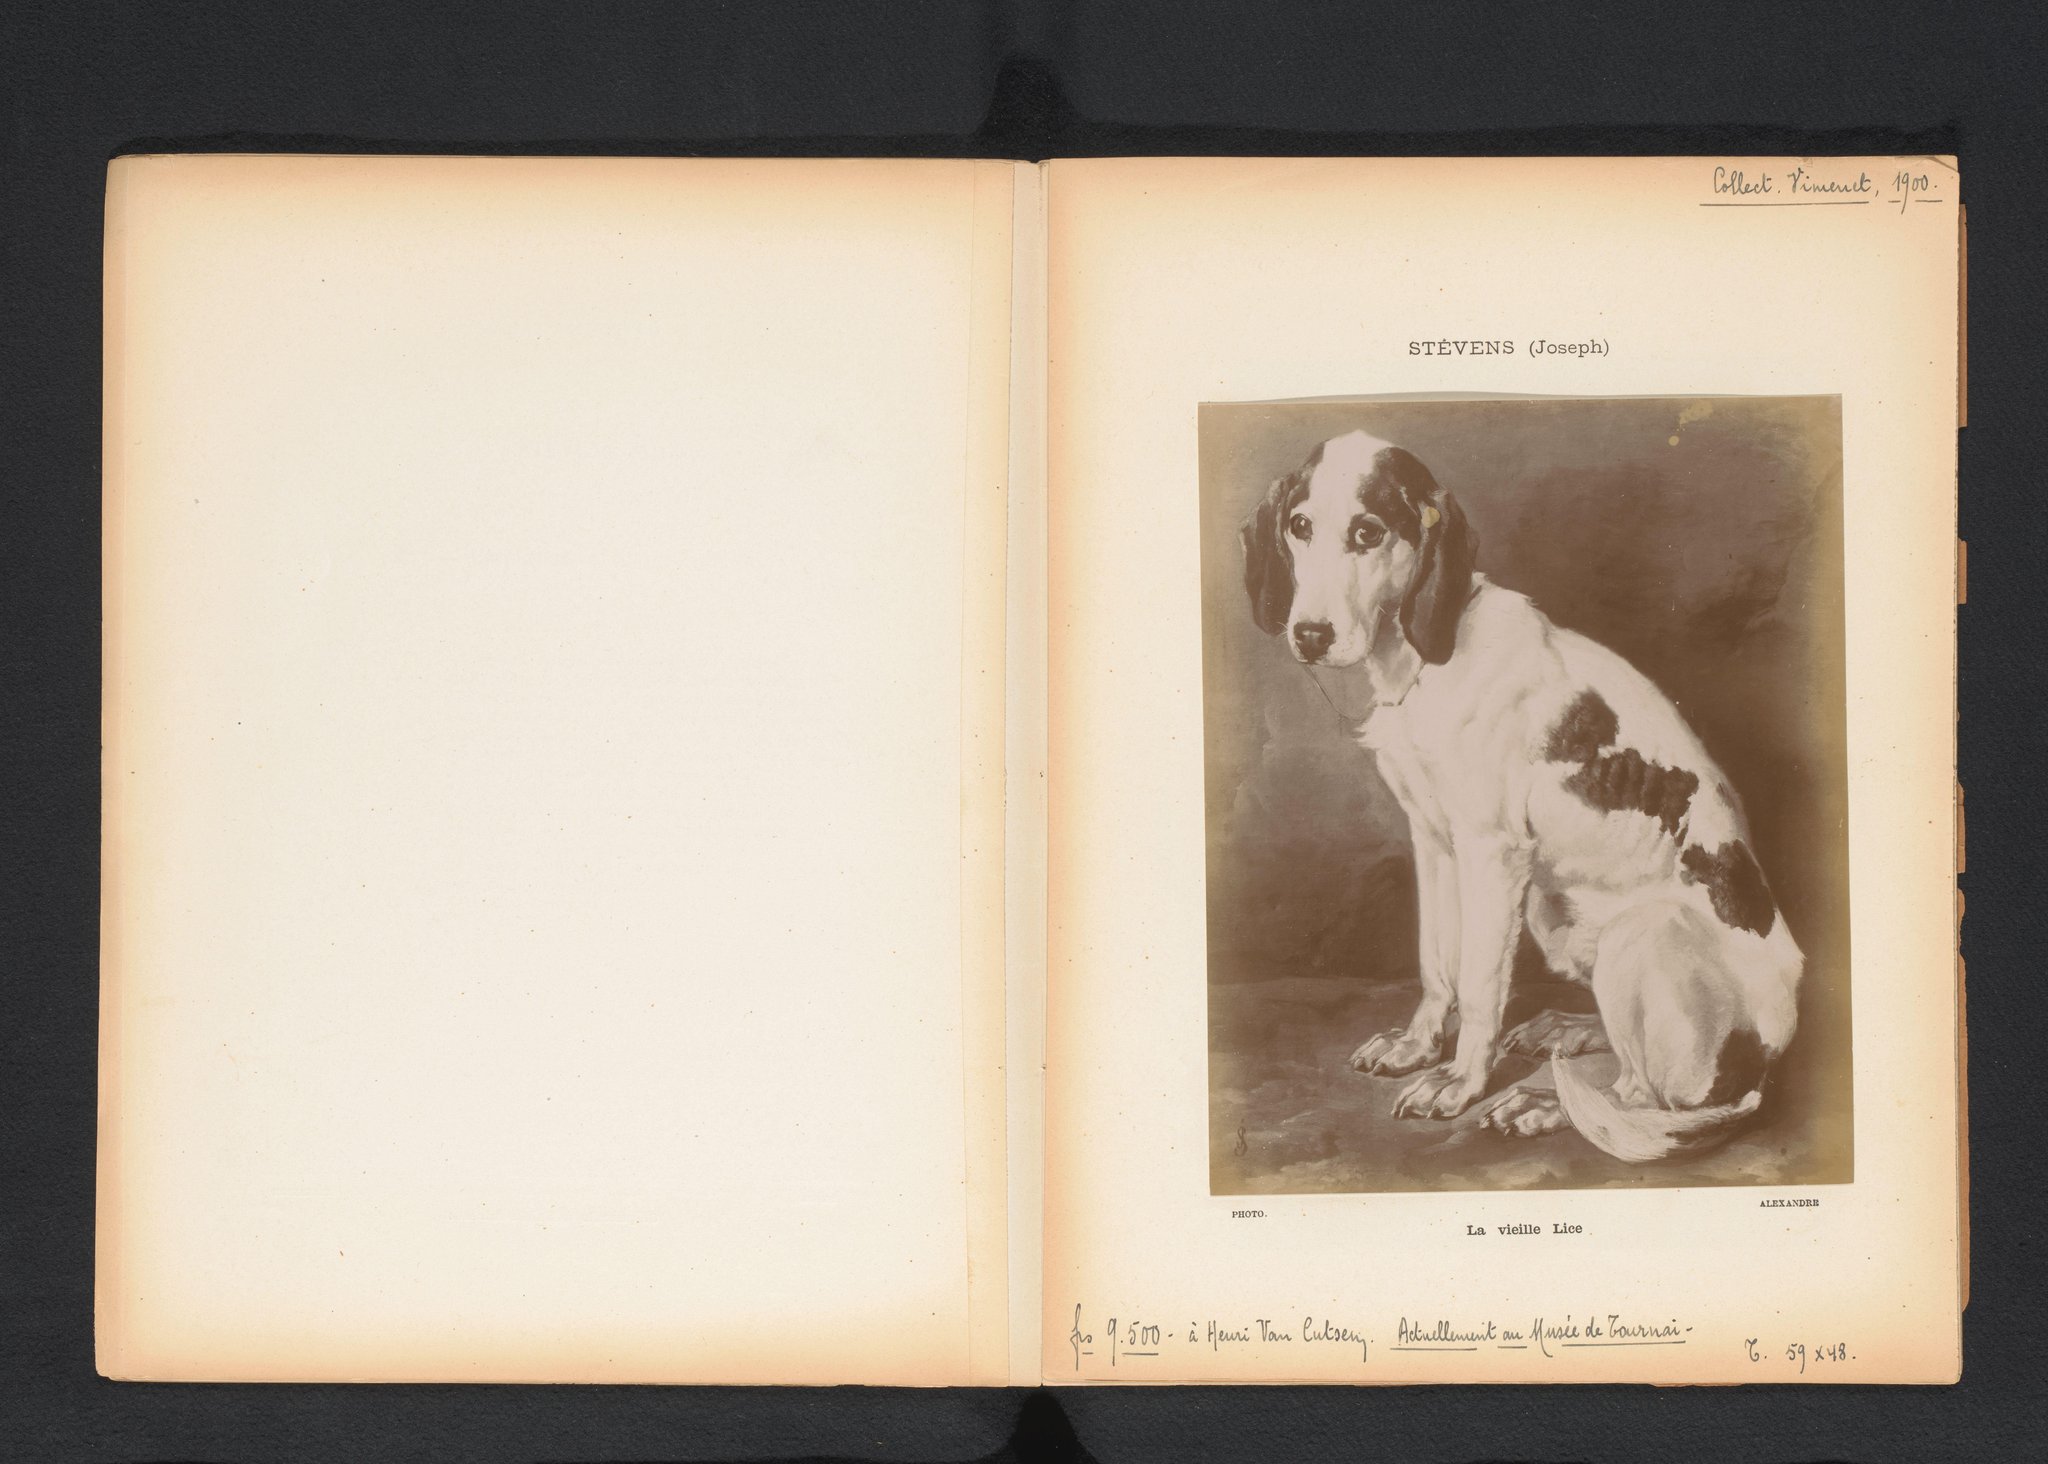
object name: photograph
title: La vieille Lice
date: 1895-1900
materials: photographic support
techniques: gelatin silver print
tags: dog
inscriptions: annotation: ‘Coll. Vimenet, 1900.’, annotation: ‘R. 59 x 48.’, annotation: ‘frs. 9.500- à Henri Van Cutseng. Actuellement au Musée de Tournai -’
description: Foto op derde ongenummerde pagina na pagina 20.